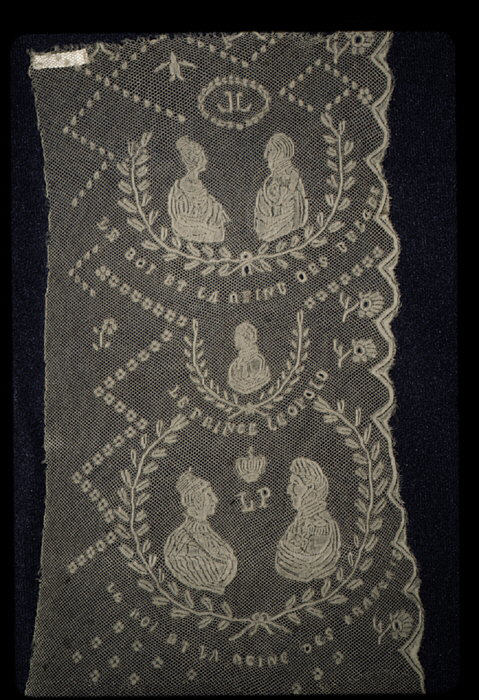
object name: piece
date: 1845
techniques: lace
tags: human figures,insignia